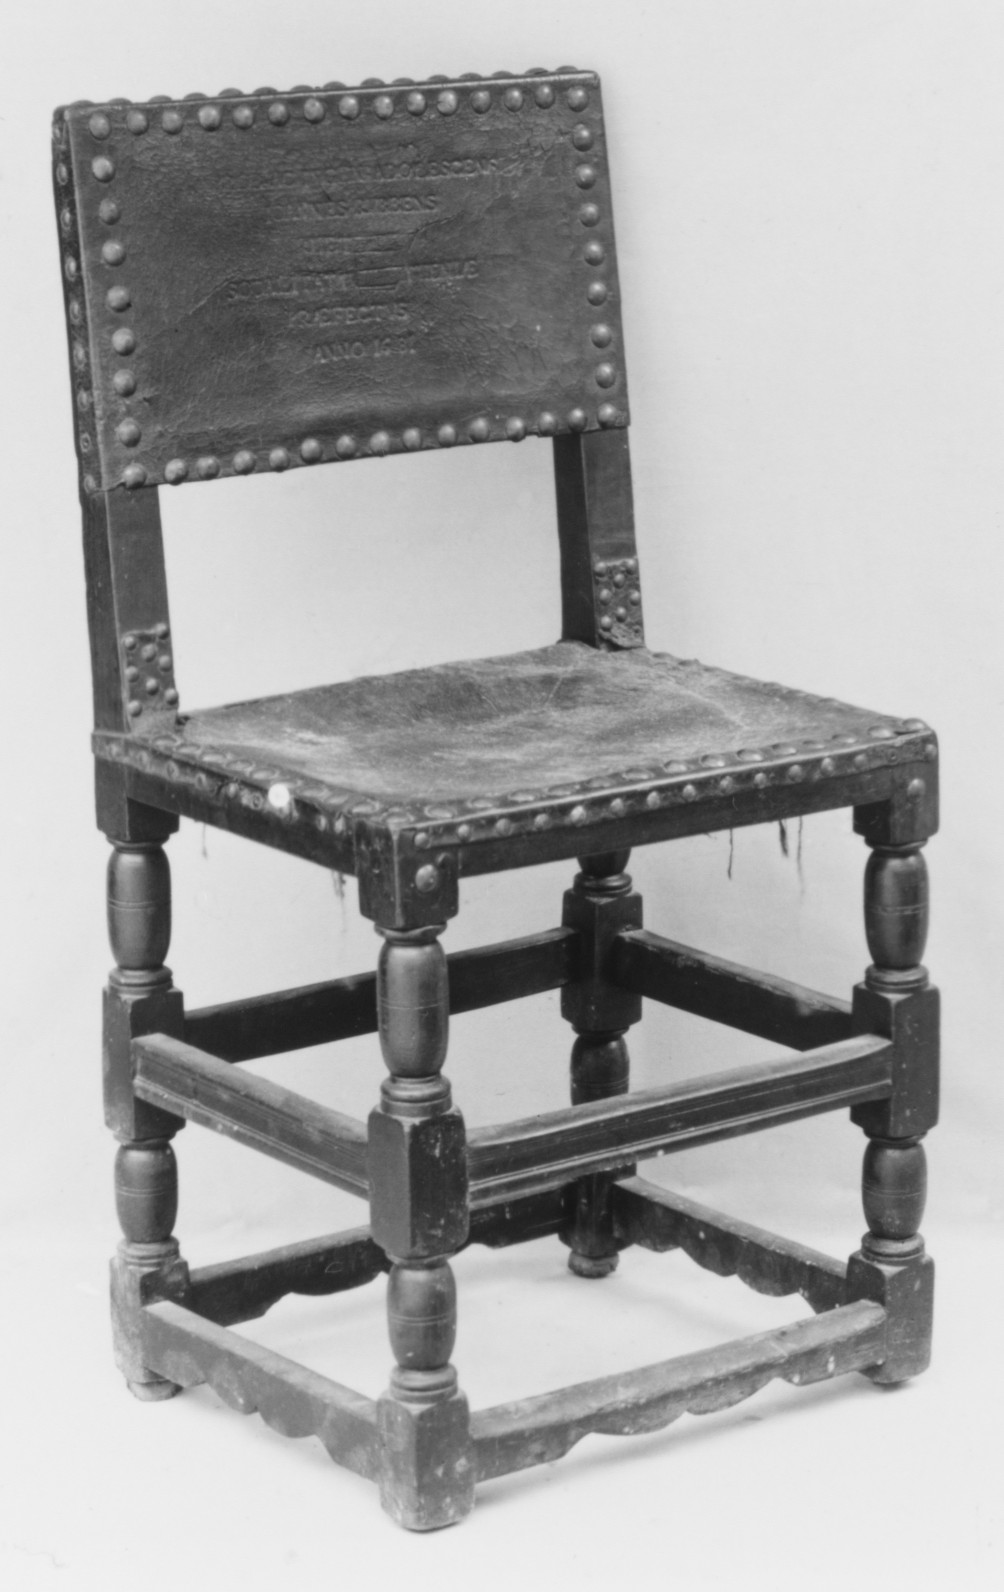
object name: chair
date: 1601-1700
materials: wood